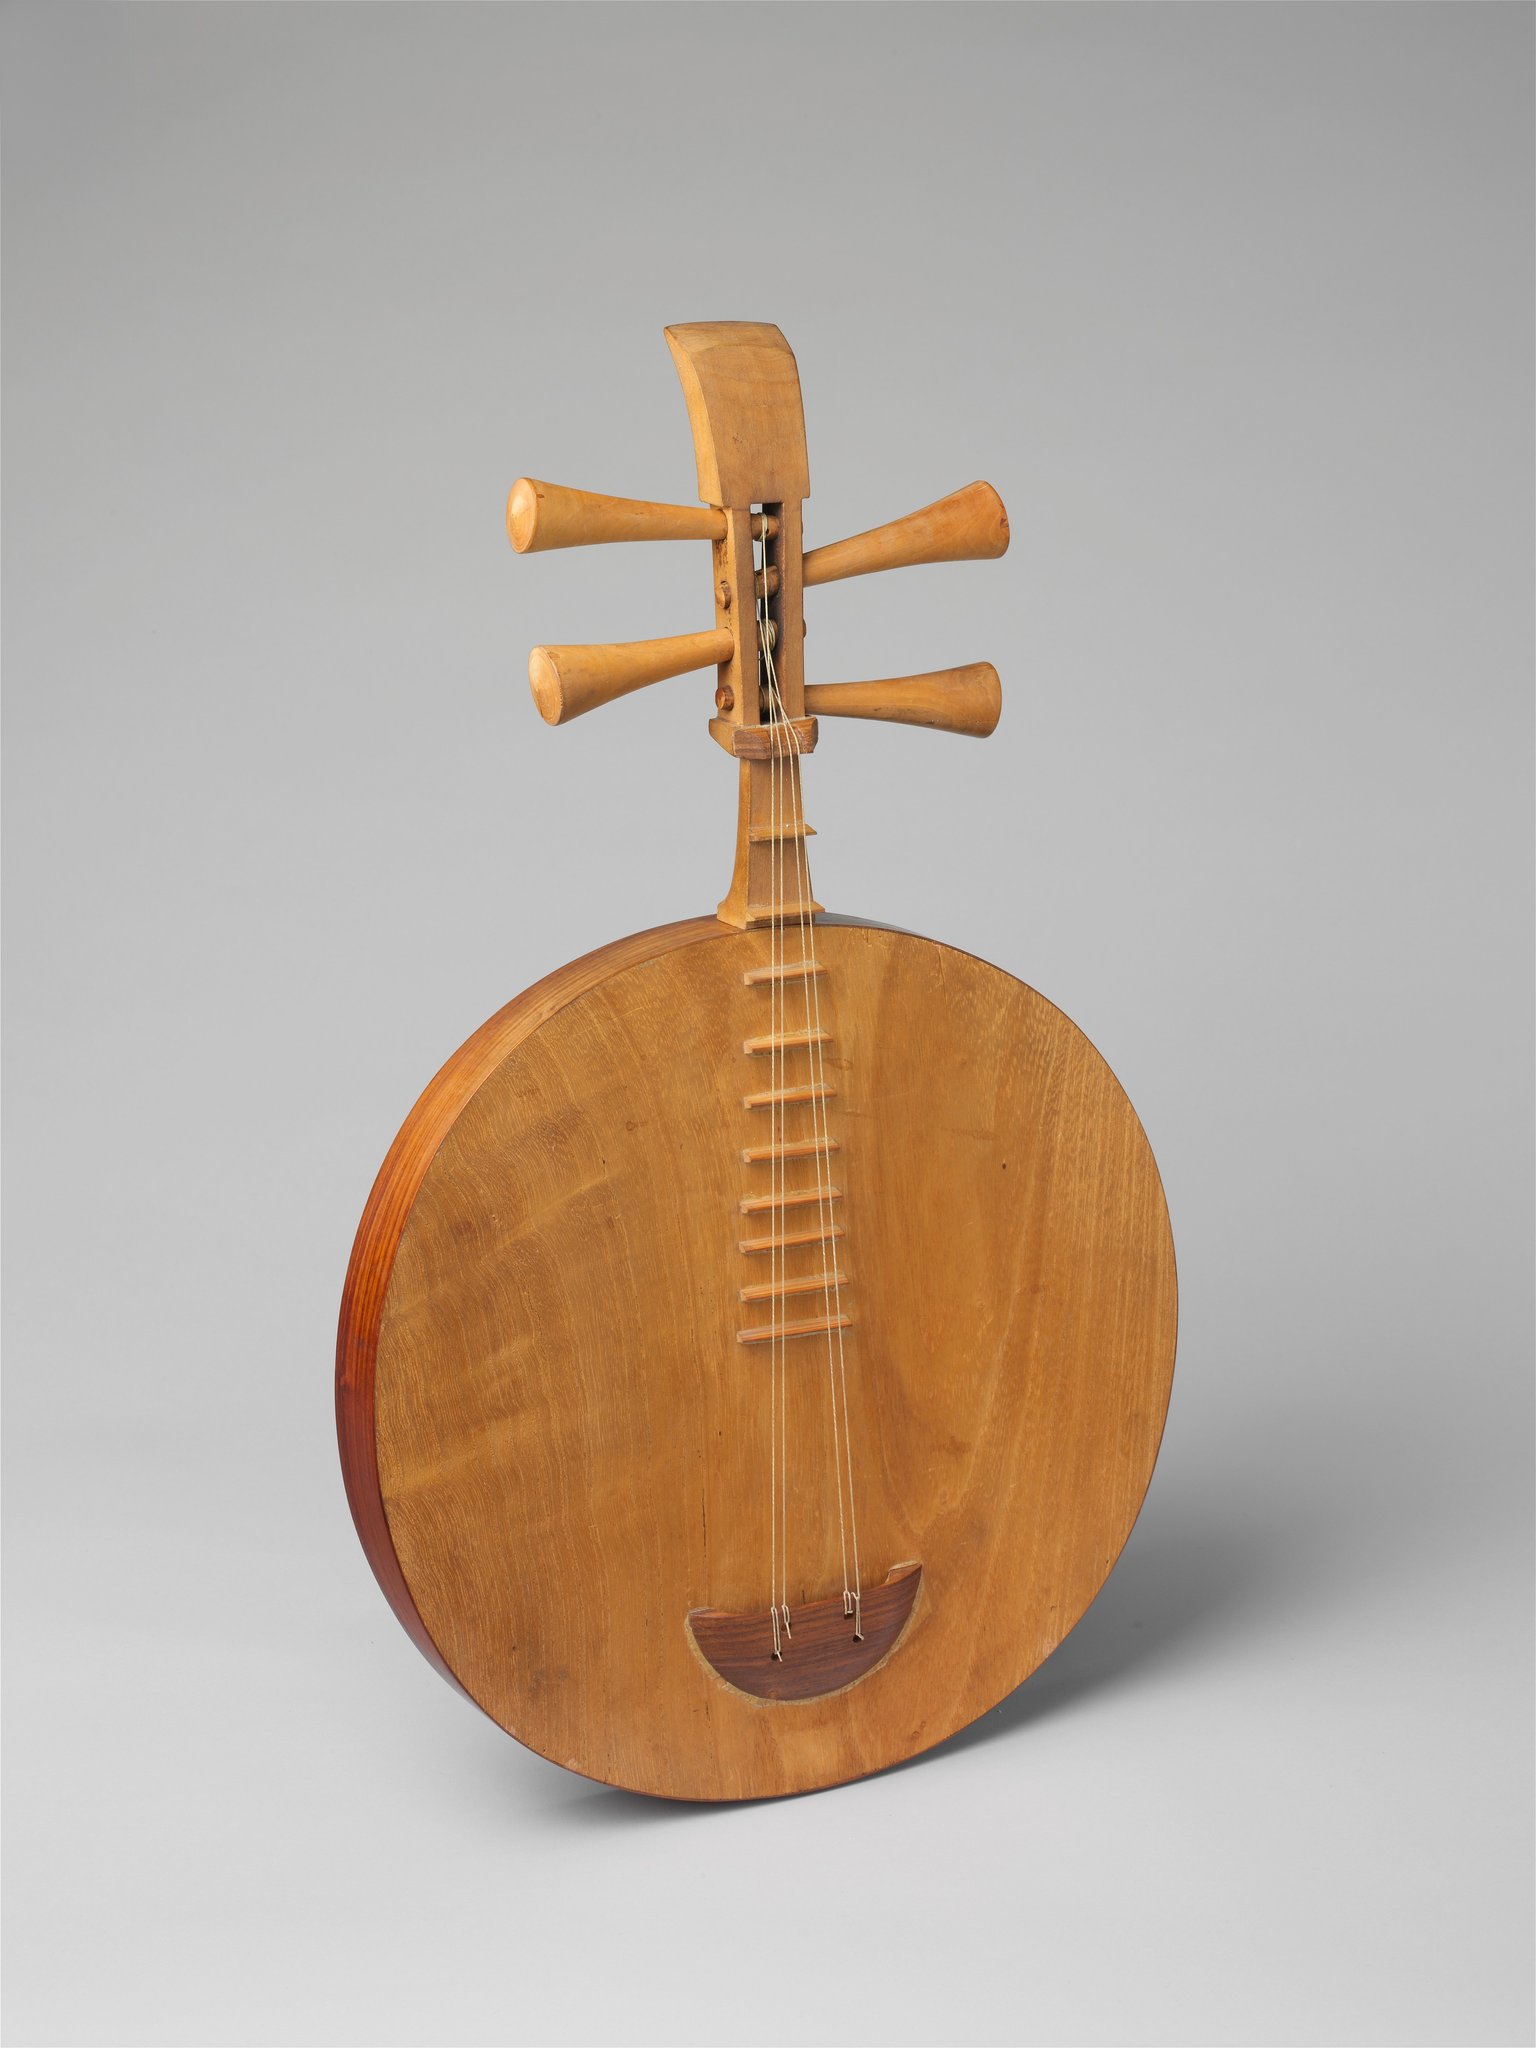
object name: yueqin moon lute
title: Yueqin (月琴)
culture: chinese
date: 1801-1900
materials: wood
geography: china